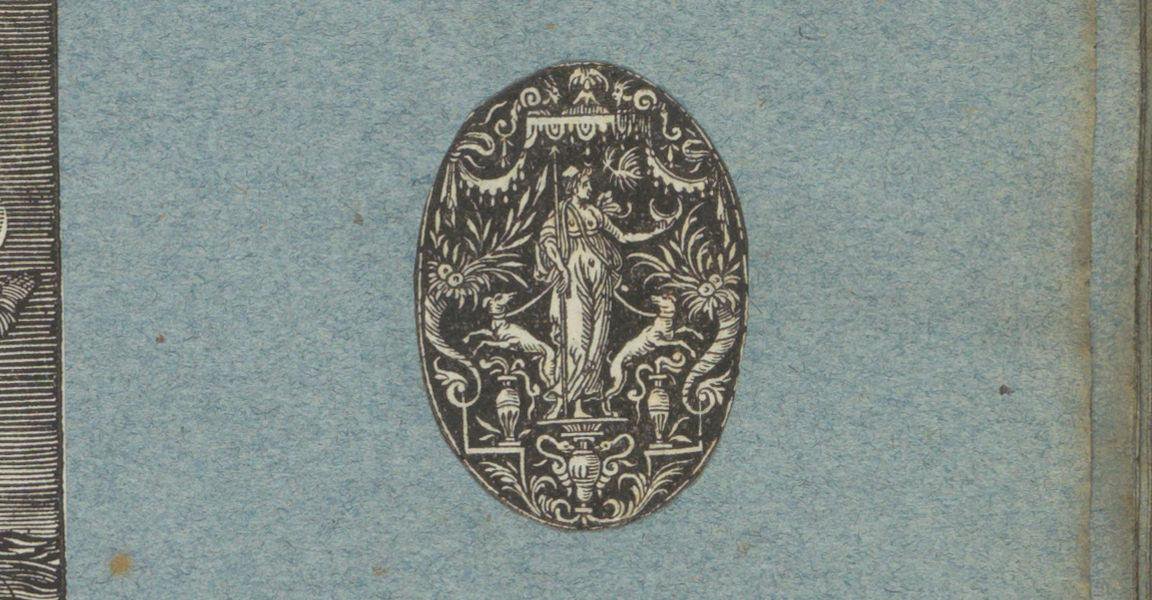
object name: print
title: Diana met de maan in haar hand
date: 1628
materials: paper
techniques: woodcut, pasting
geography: amsterdam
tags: 'cornucopia', horn of plenty, ornamental decoration ~ printed matter, book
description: Ornament uit: Herman Hugo, Pia desideria emblematis, elegiis & affectibus S. S. Patrum illustrata, Antwerpen 1628. Volgens de titelpagina verscheen dit werk in Antwerpen bij Hendrick Aertssens, in werkelijkheid verscheen het in Amsterdam bij Pieter Jacobsz Paets (Dietz 2012, p. 58-59).